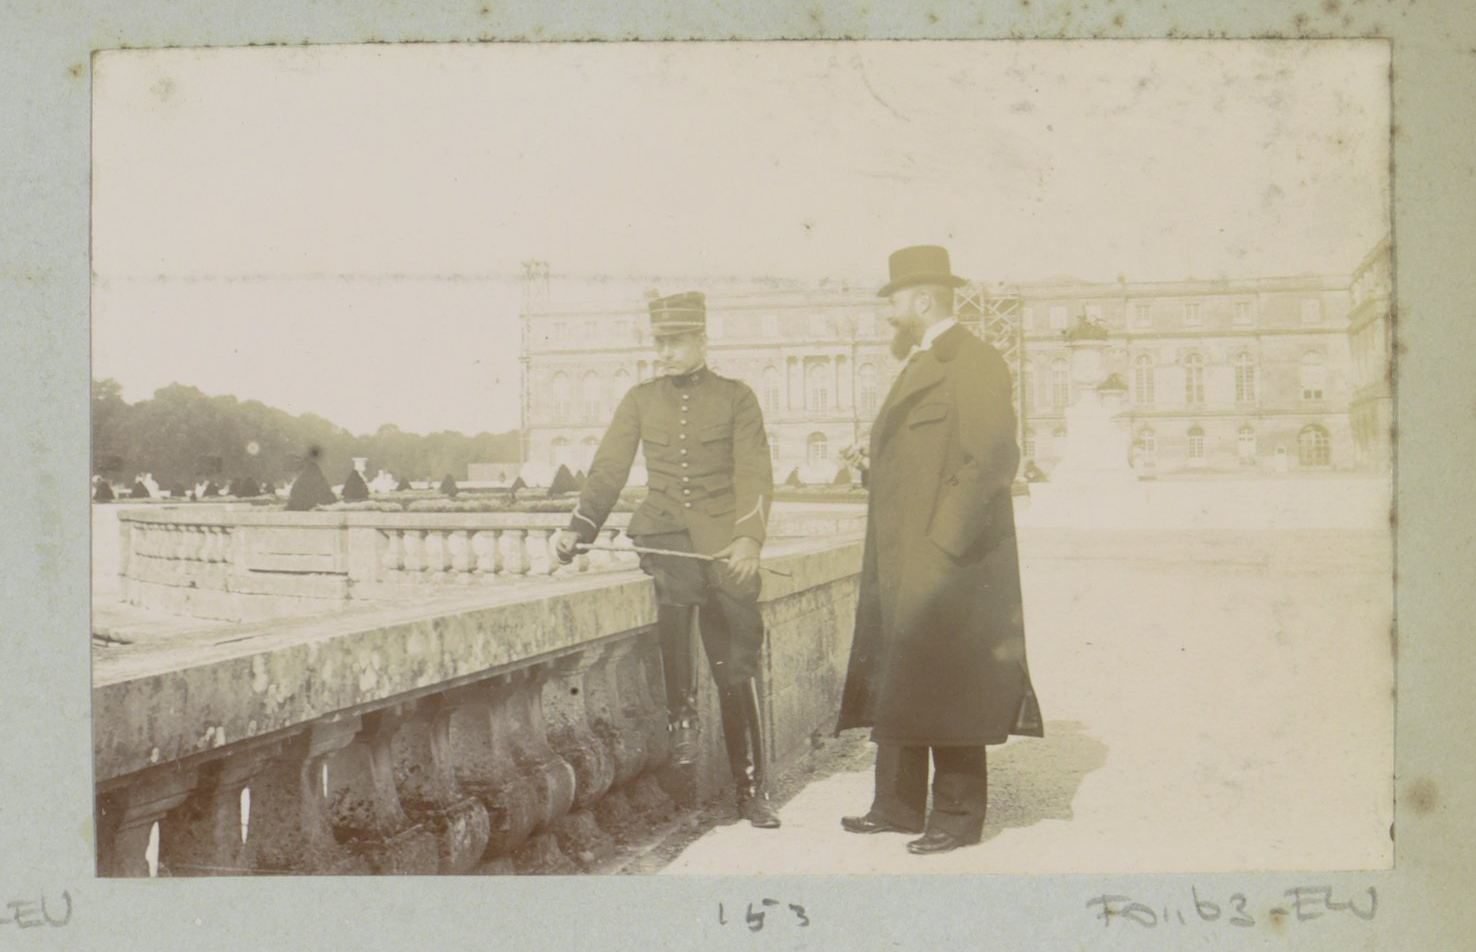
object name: photograph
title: Twee mannen waarvan één geüniformeerd in een park, mogelijk Versailles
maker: delizy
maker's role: manufacturer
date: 1897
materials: paper, photographic support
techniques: gelatin silver print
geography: france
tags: adult man, (military) uniforms, public gardens, park, france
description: Onderdeel van Fotoalbum van een Franse amateurfotograaf met opnames van uitstapjes in Frankrijk, Spanje, België, Luxemburg en Nederland, de eerste automobielen en autoraces.